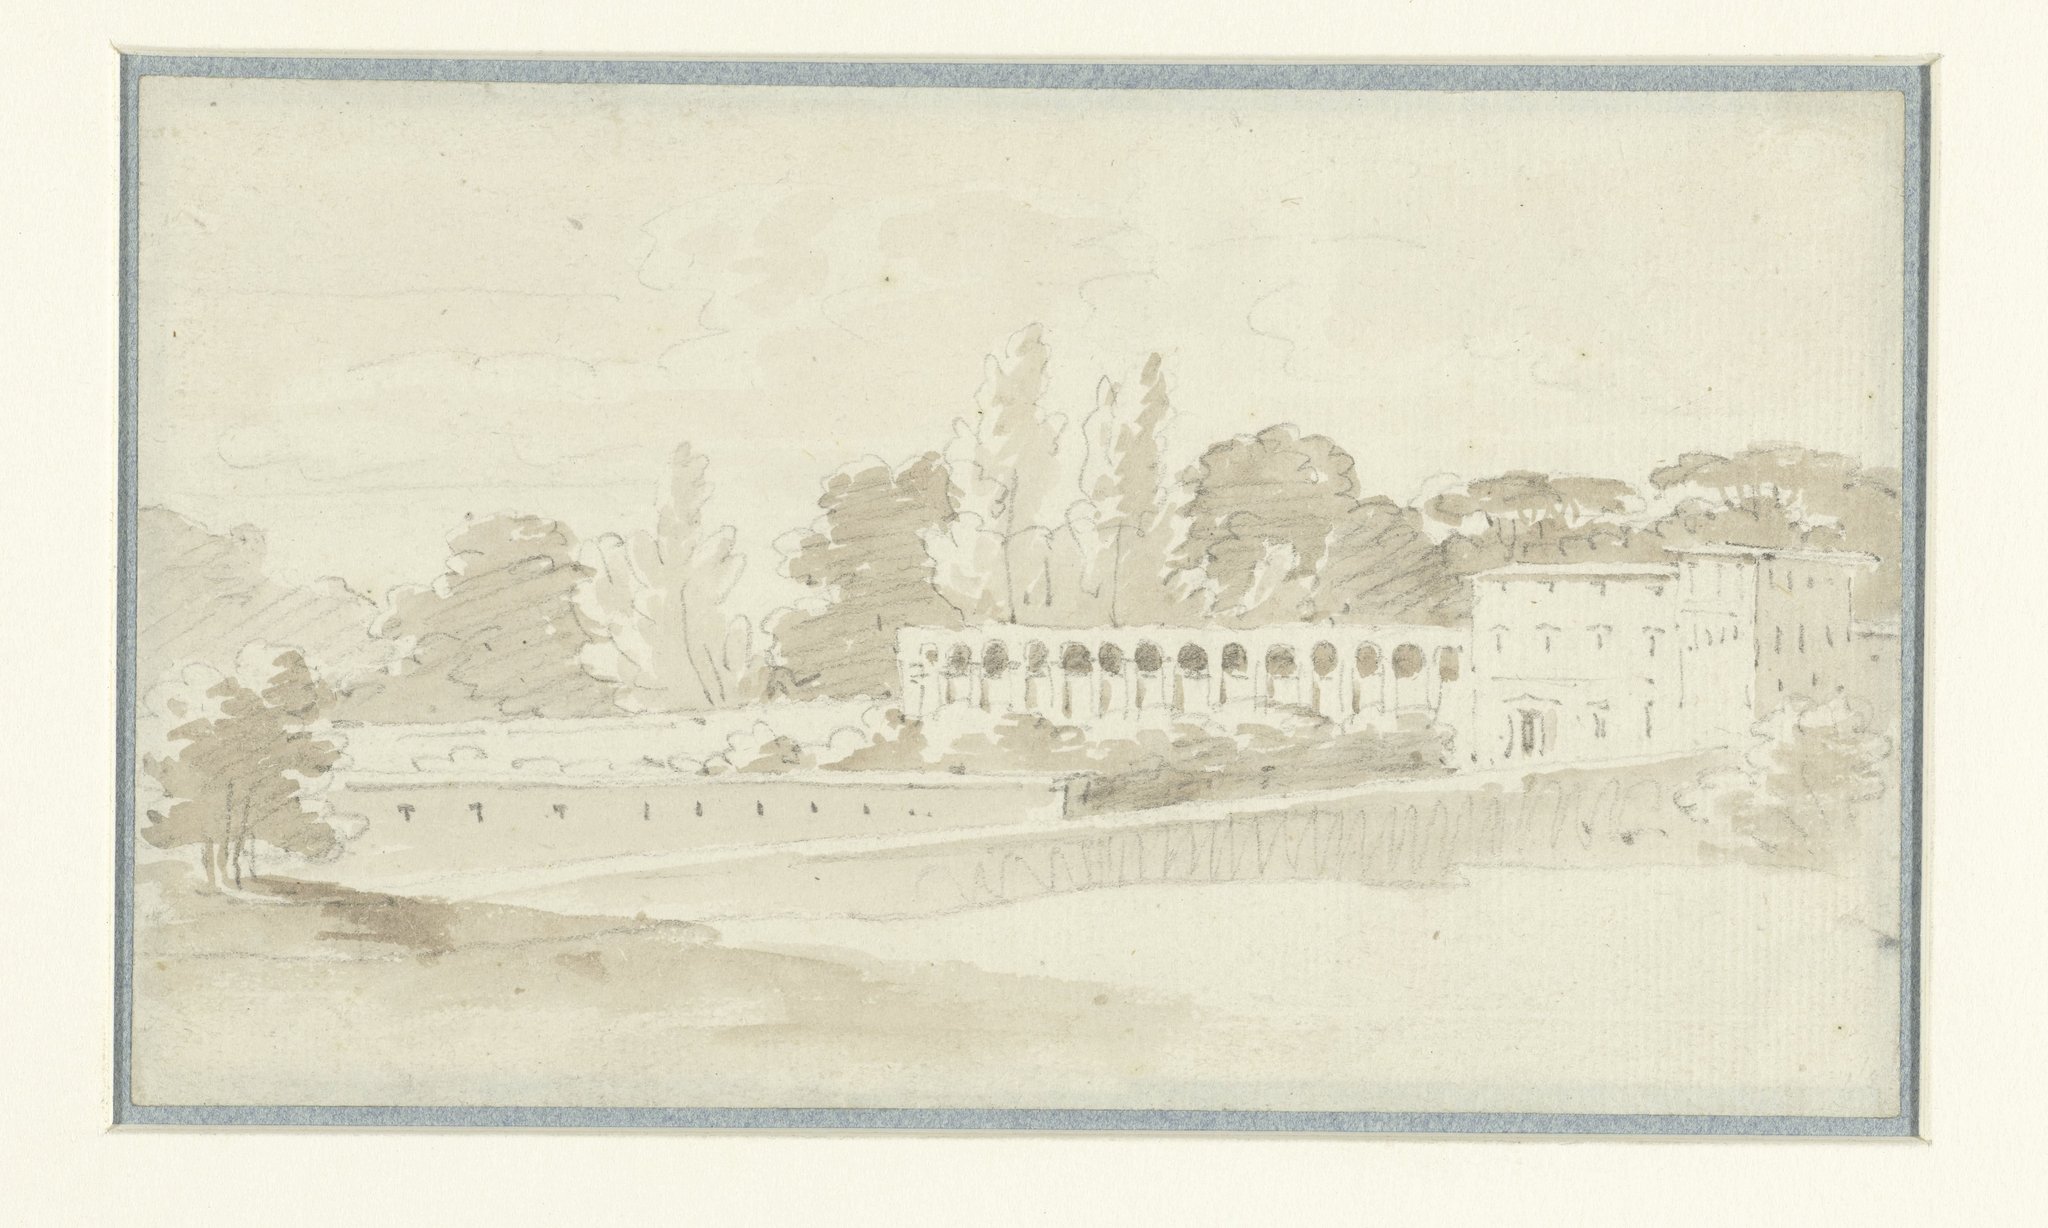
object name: drawing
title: Gezicht bij het Casino Borghese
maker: etienne de lavallée-poussin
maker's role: draughtsman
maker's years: 1733-1793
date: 1762-1777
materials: paper, pencil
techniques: brush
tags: villa, farm or solitary house in landscape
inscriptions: collector's mark, verso, on the mount, lower right: Lugt 2228